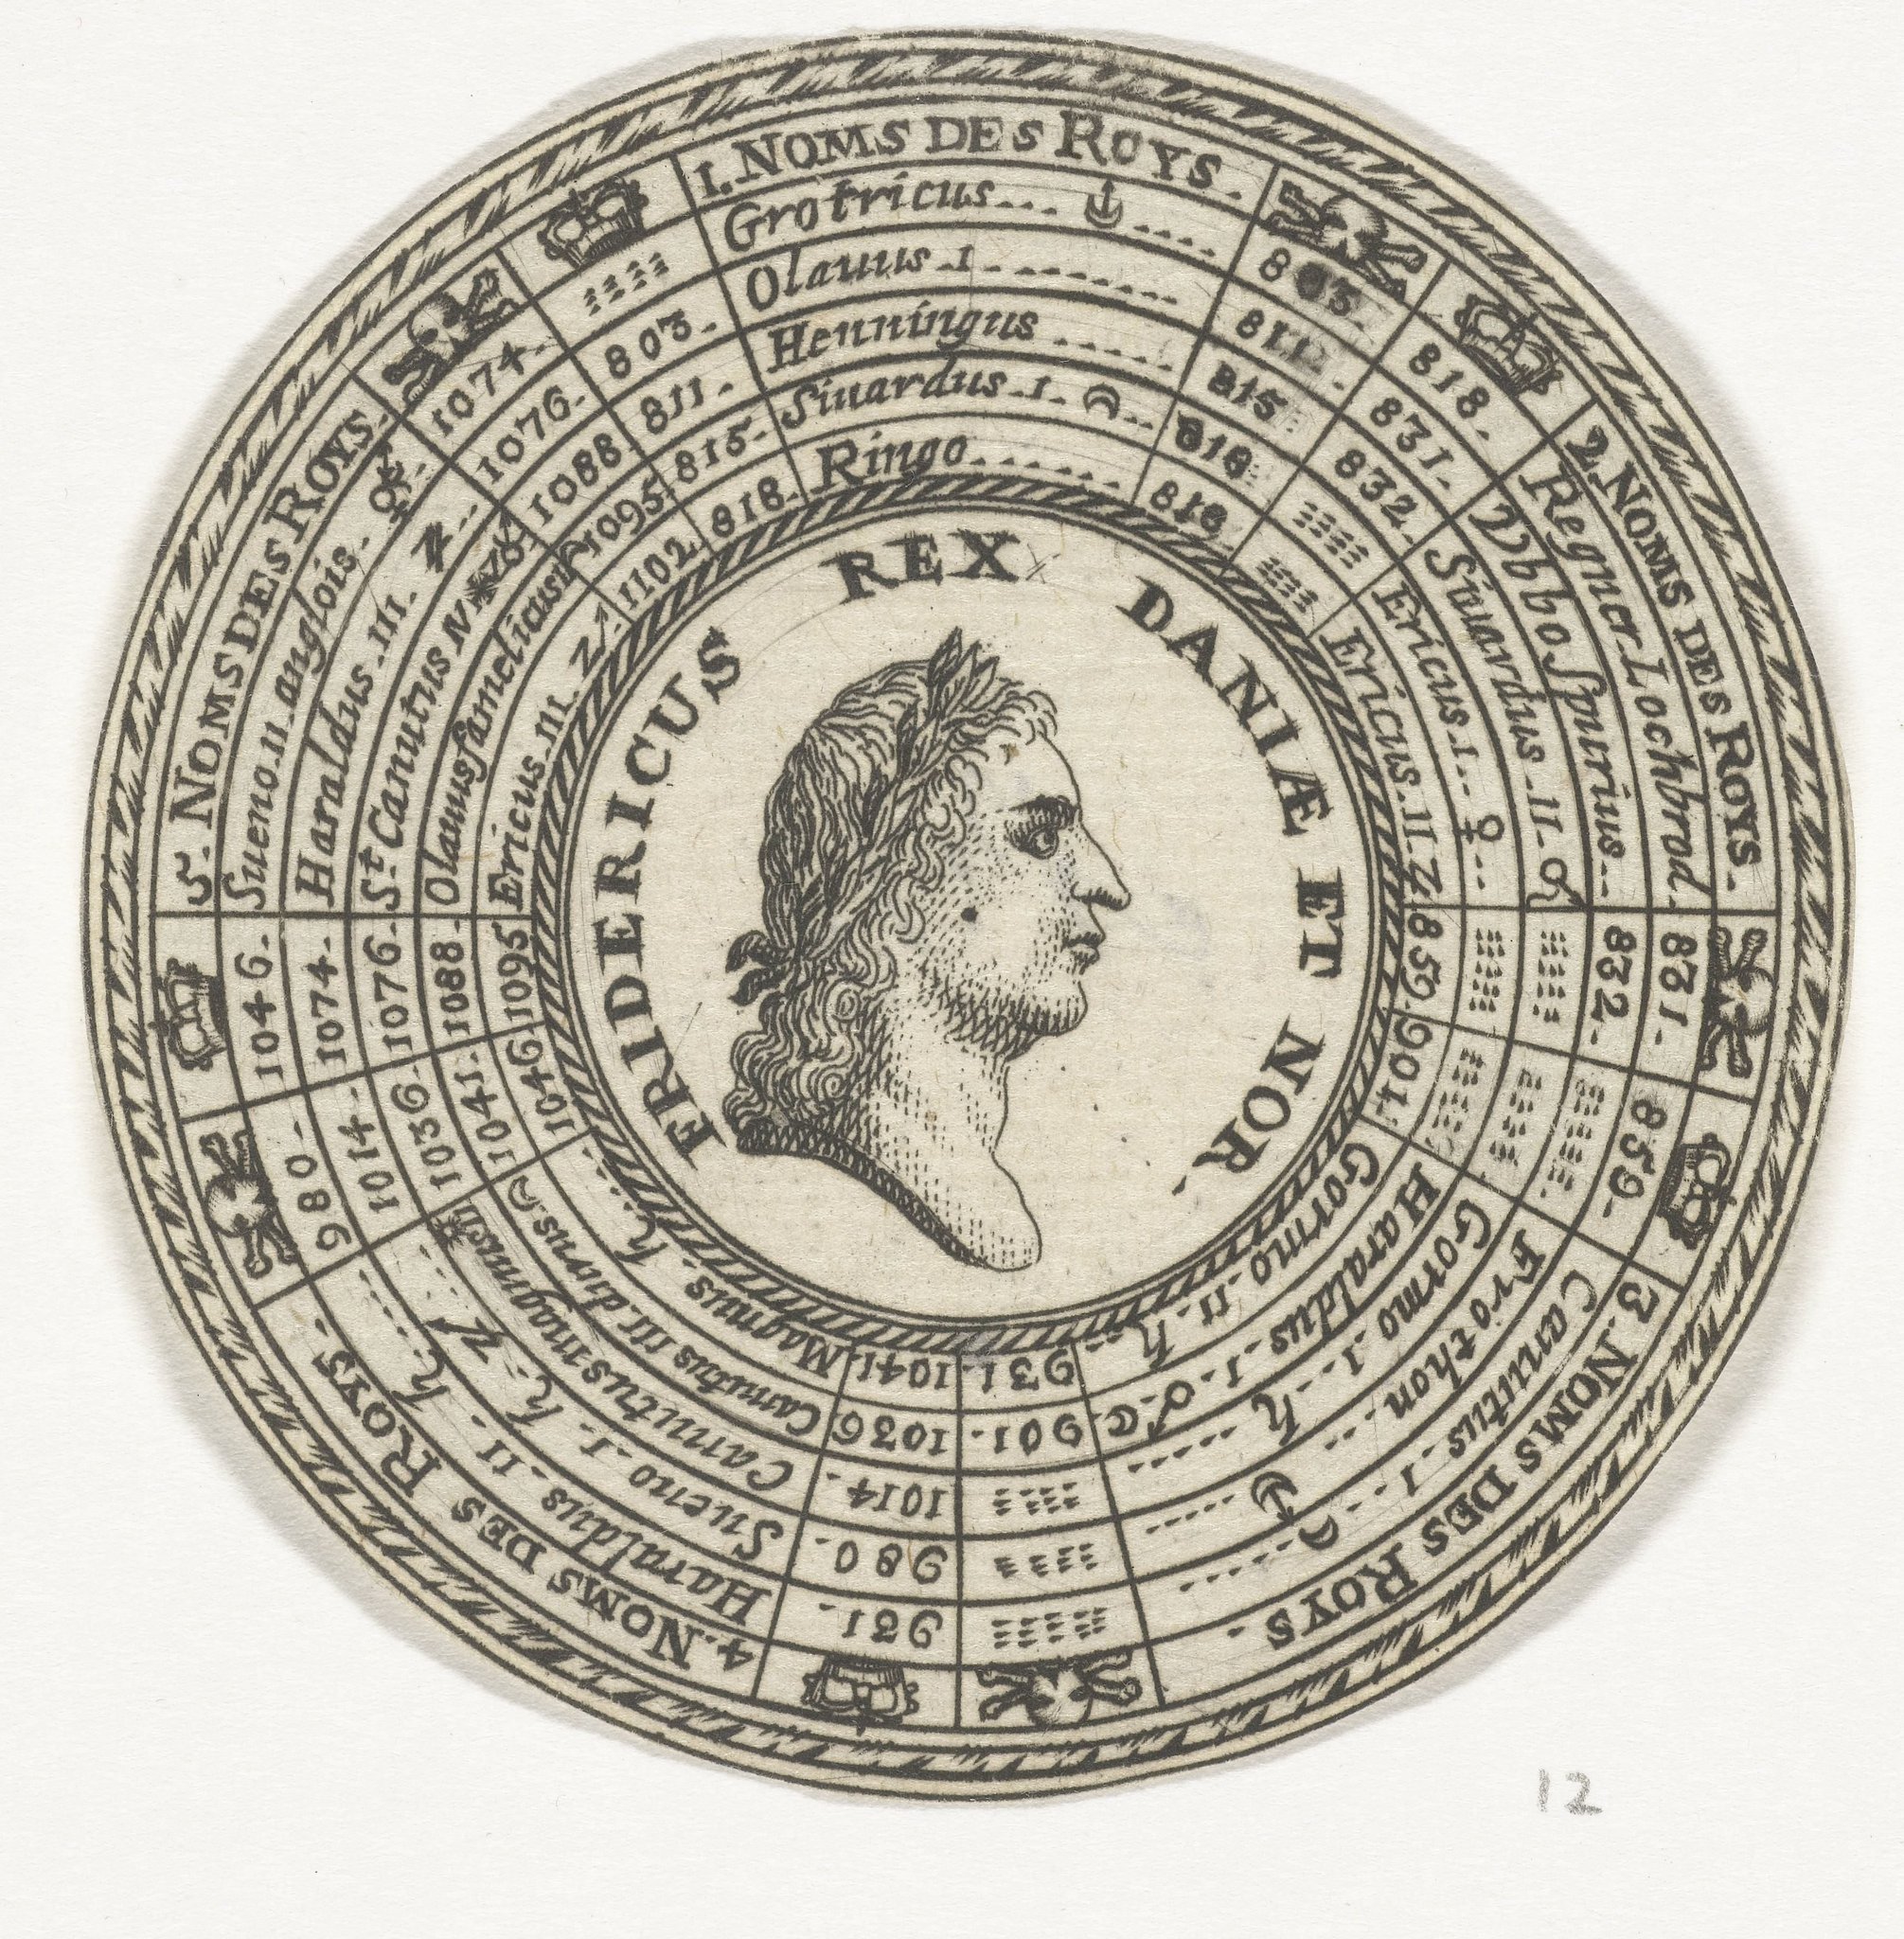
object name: print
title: Penning met het portret van Frederik IV en de namen van Deense koningen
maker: Anonymous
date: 1685-1720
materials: paper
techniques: etching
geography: amsterdam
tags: copenhagen (city), frederik iv (koning van denemarken en noorwegen), king, seal (symbol of sovereignty)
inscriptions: number: ‘13’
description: Ontwerp van een ronde penning met, in zes concentrische cirkels, de namen van Deense koningen en hun regeringsjaren, beginnende bij koning Grotricus (?) en eindigend bij koning Eric III. In het midden van de penning het portret van Frederik IV.